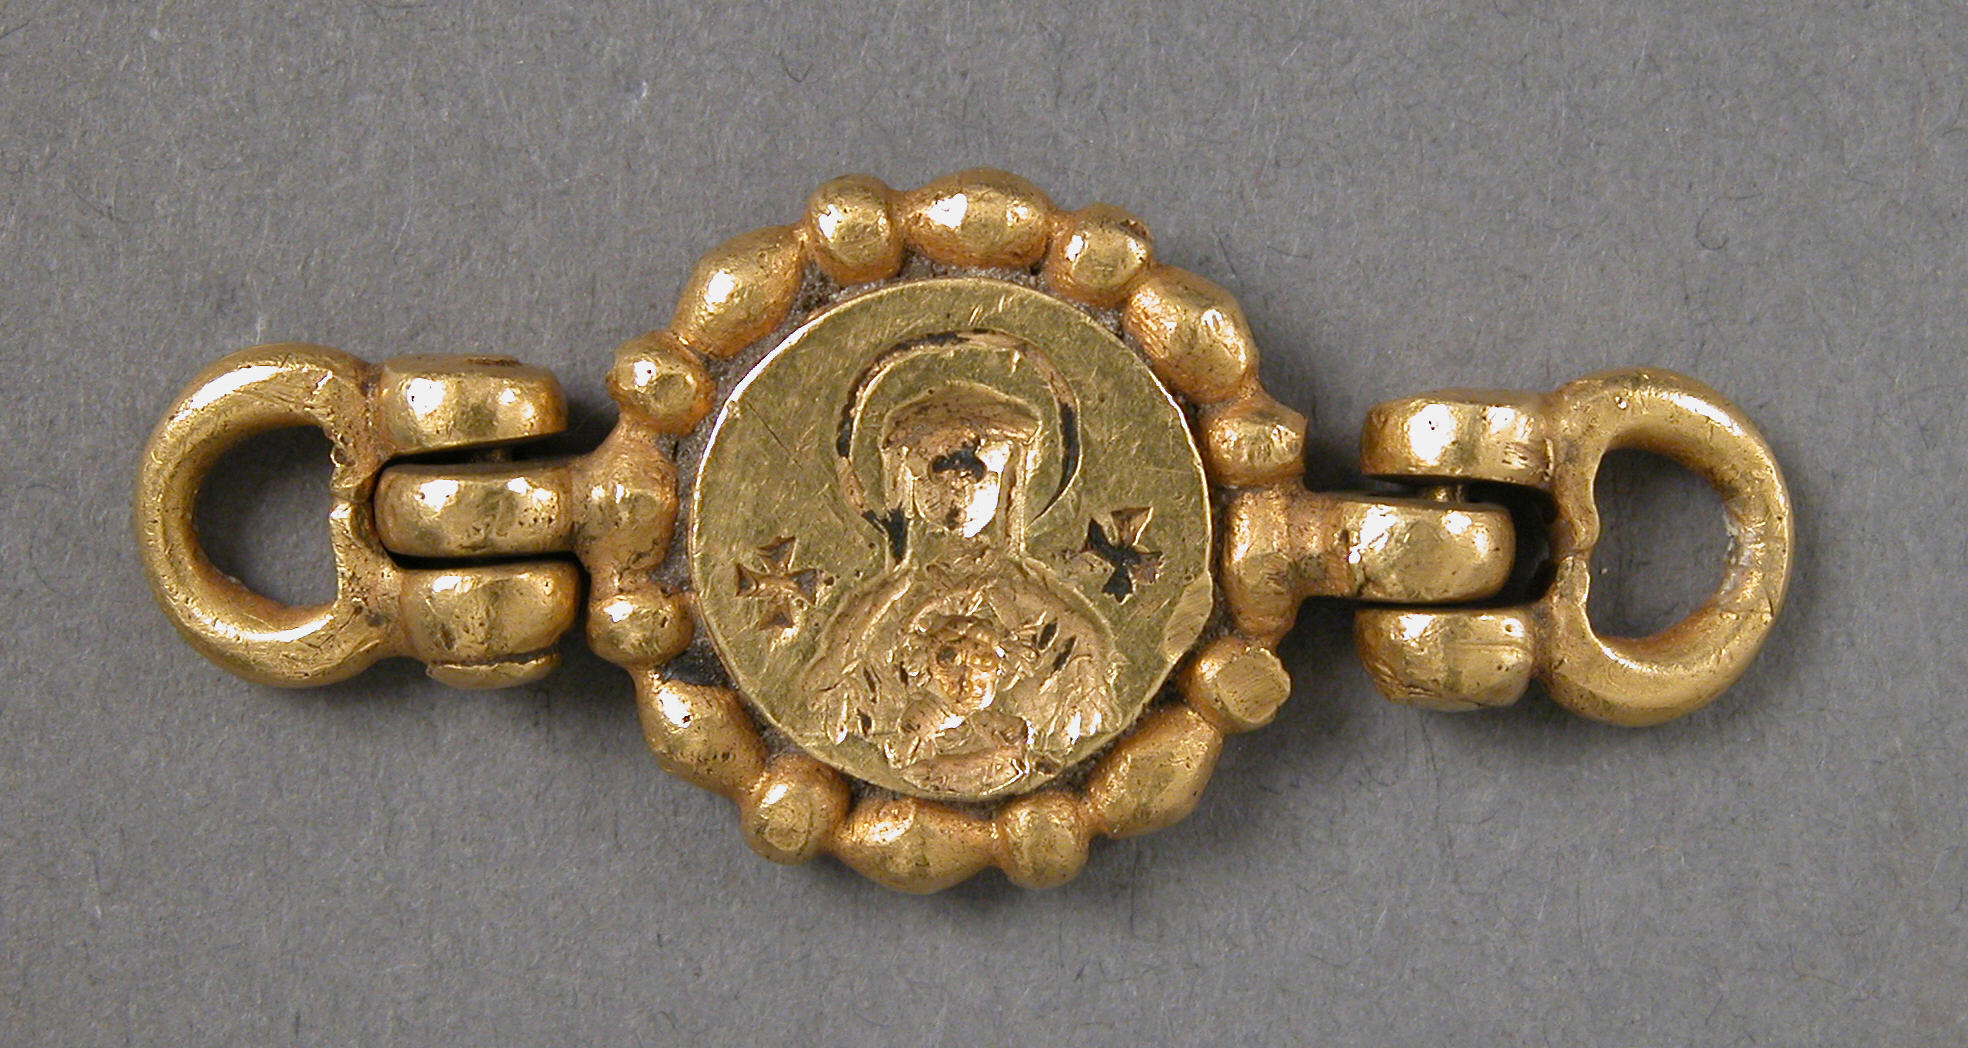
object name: clasp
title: Clasp with Intaglio Medallion of the Virgin and Child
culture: byzantine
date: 501-600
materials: gold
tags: madonna and child